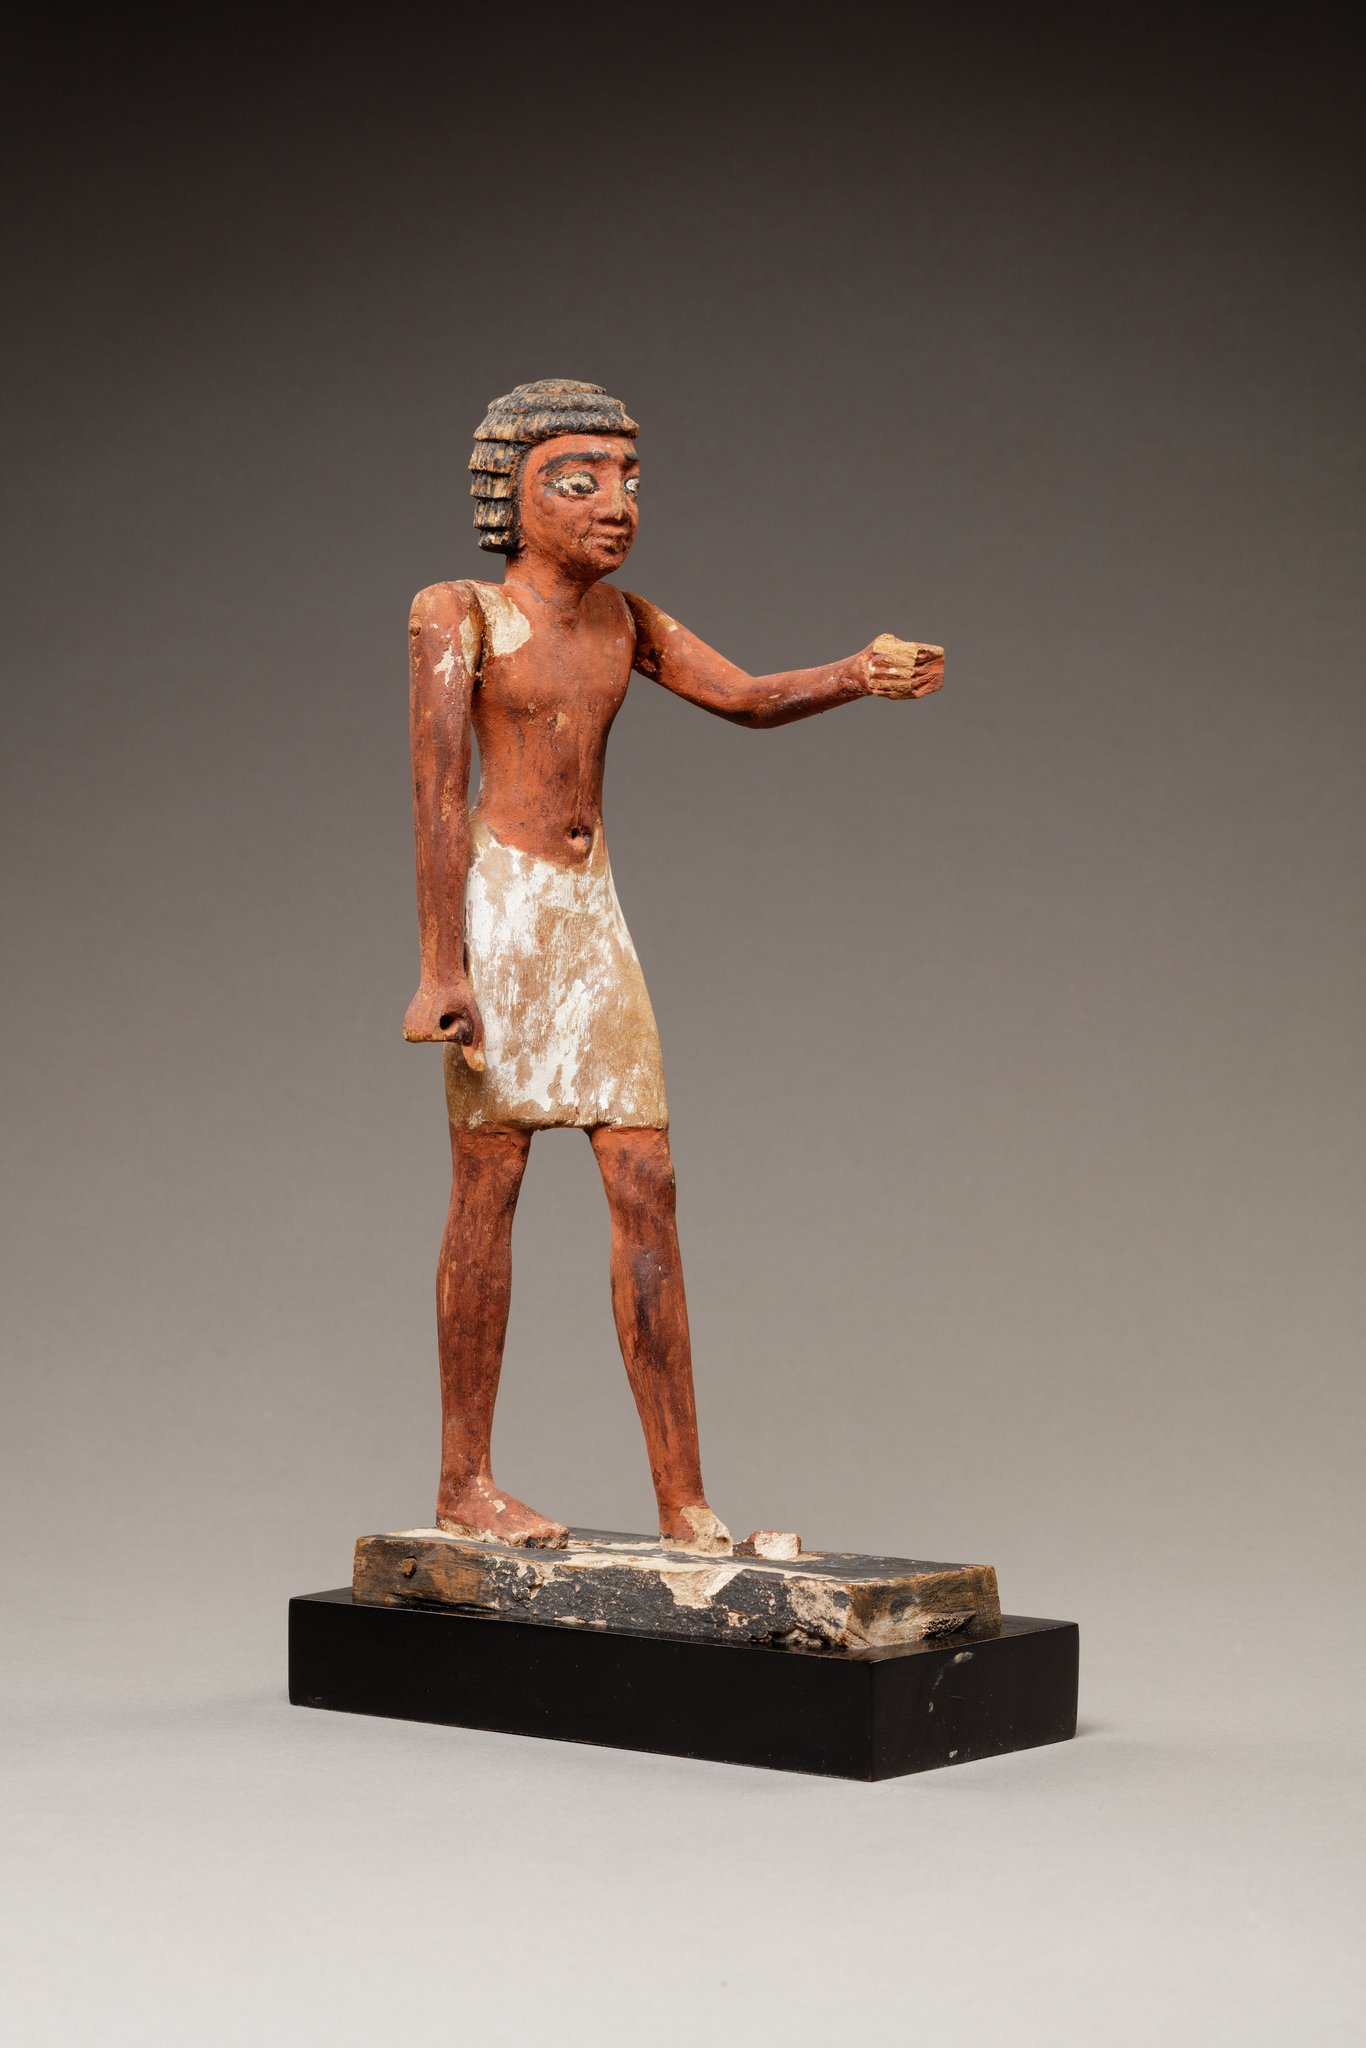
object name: statuette of a striding man in a kilt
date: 2030-1917 BCE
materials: paint, paste, wood